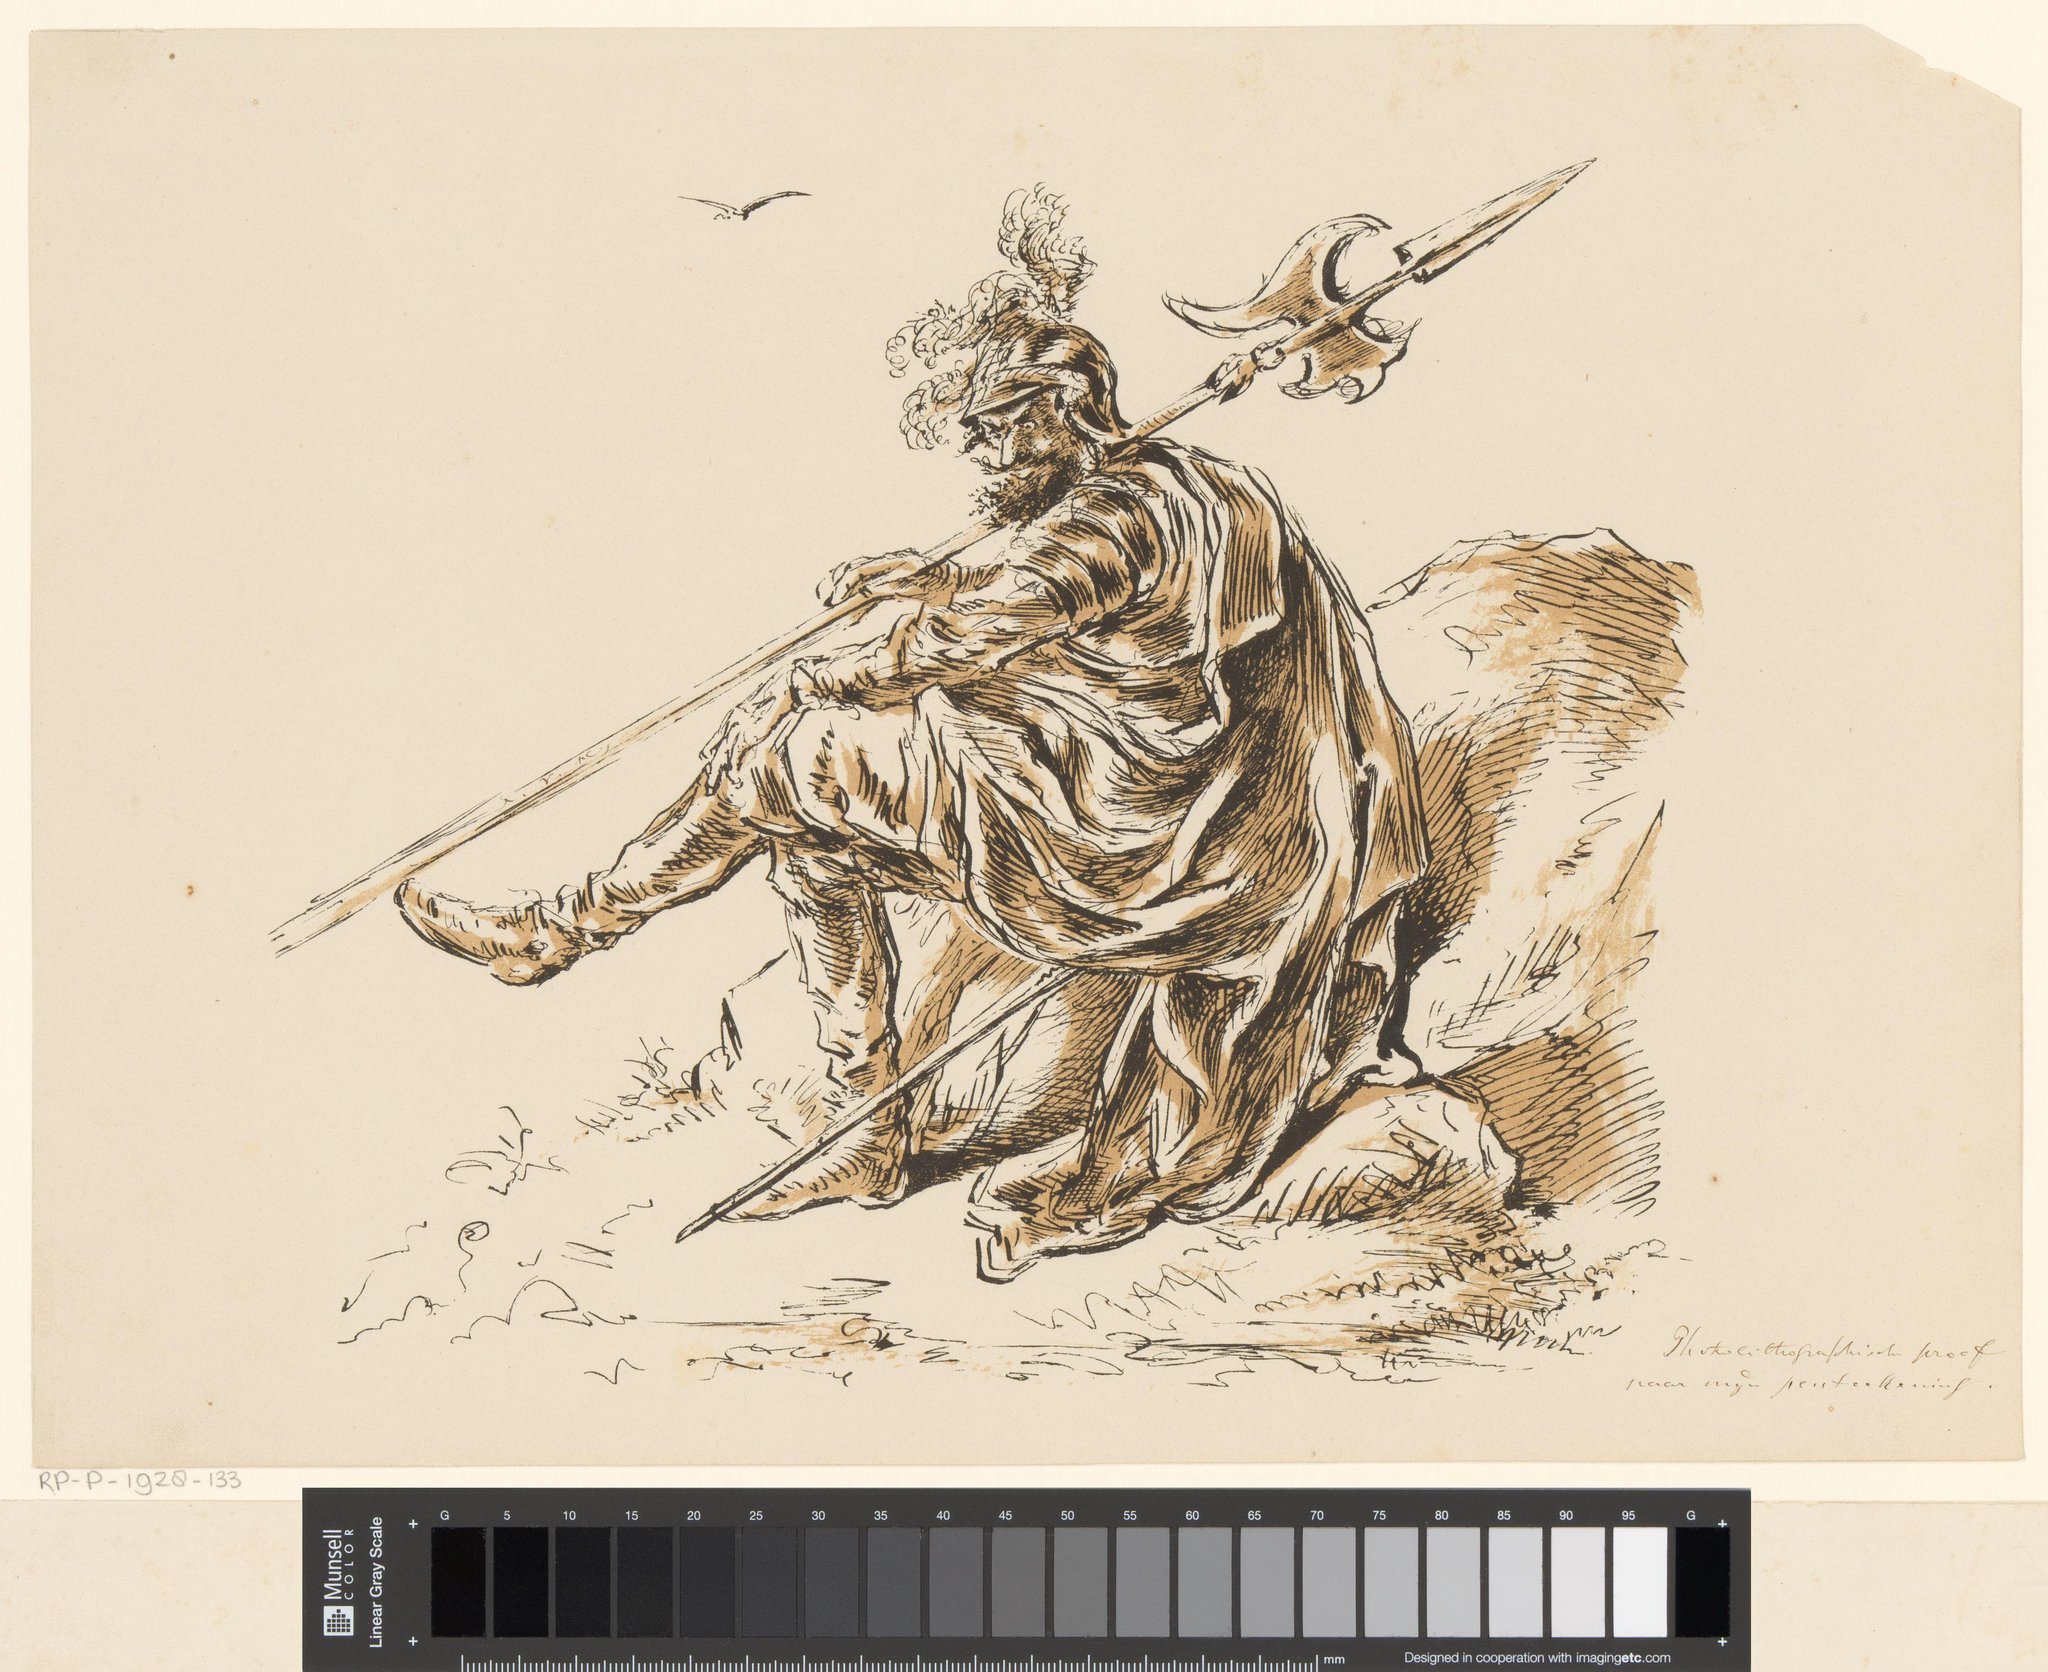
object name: print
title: Zittende krijgsman met hellebaard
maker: alexander ver huell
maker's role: draughtsman, print maker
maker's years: 1822-1897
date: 1832-1897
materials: paper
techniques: photolithography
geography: netherlands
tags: the soldier; the soldier's life, helved weapons, polearms (for striking, hacking, thrusting): halberd